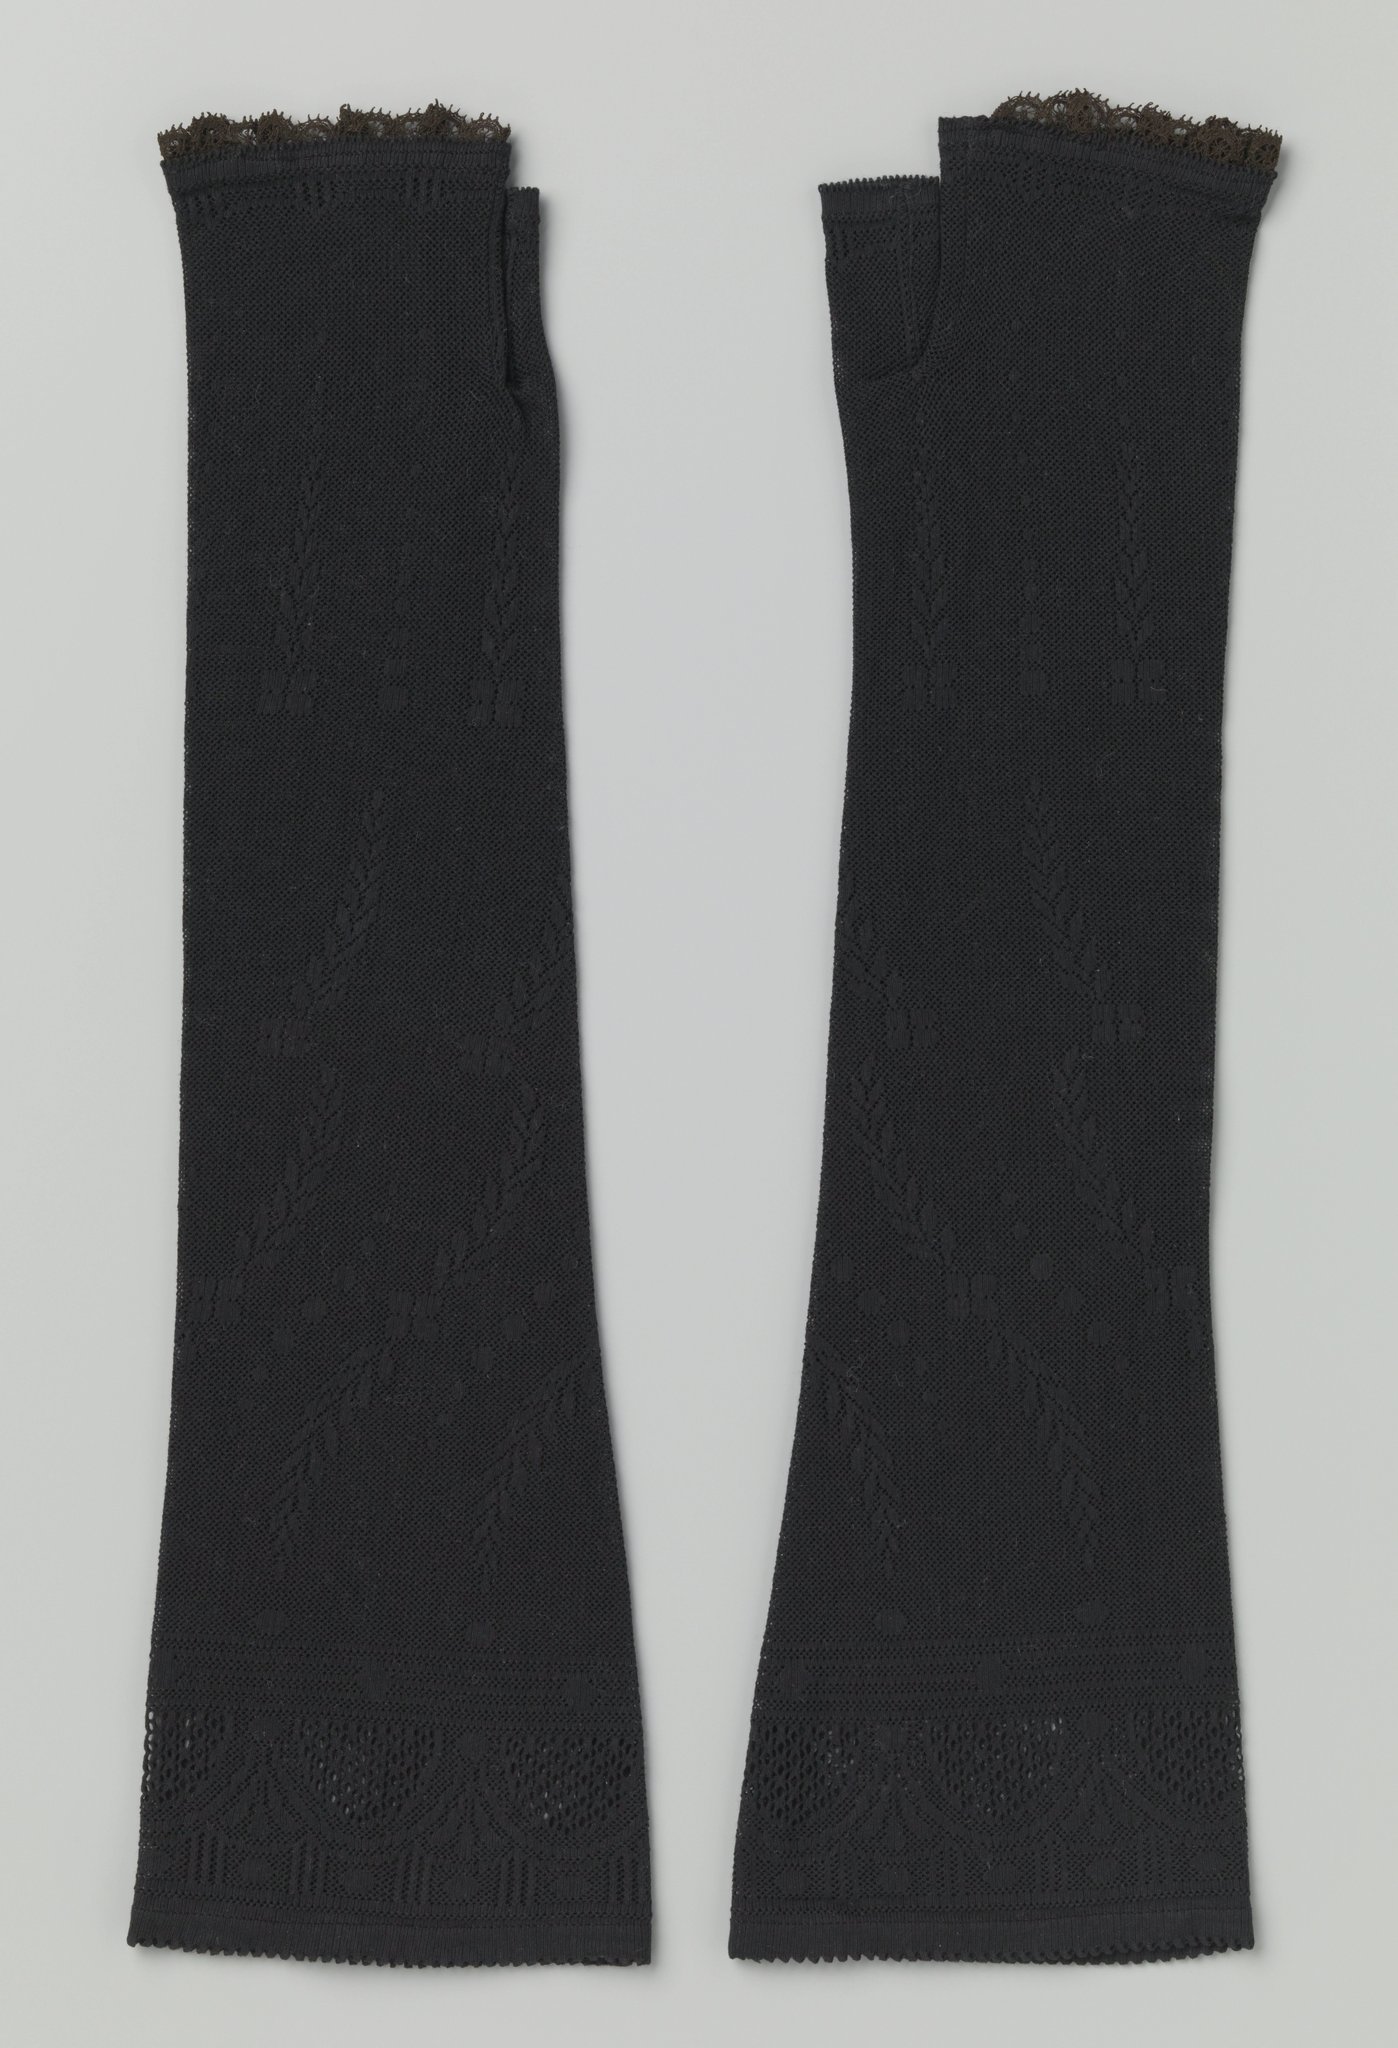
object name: clothing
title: Mitaine van zwarte katoen in machinaal kant, met losse duim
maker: Anonymous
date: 1900-1925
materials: cotton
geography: western europe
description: Linker mitaine van zwart katoen in machinaal kant. Recht afgesneden over de hand, met losse duim. Afgezet met een smal randje bruin kant. Ornament van bladeren, waartussen pastilles. Aan de bovenkant een rand met architectonische vormen.